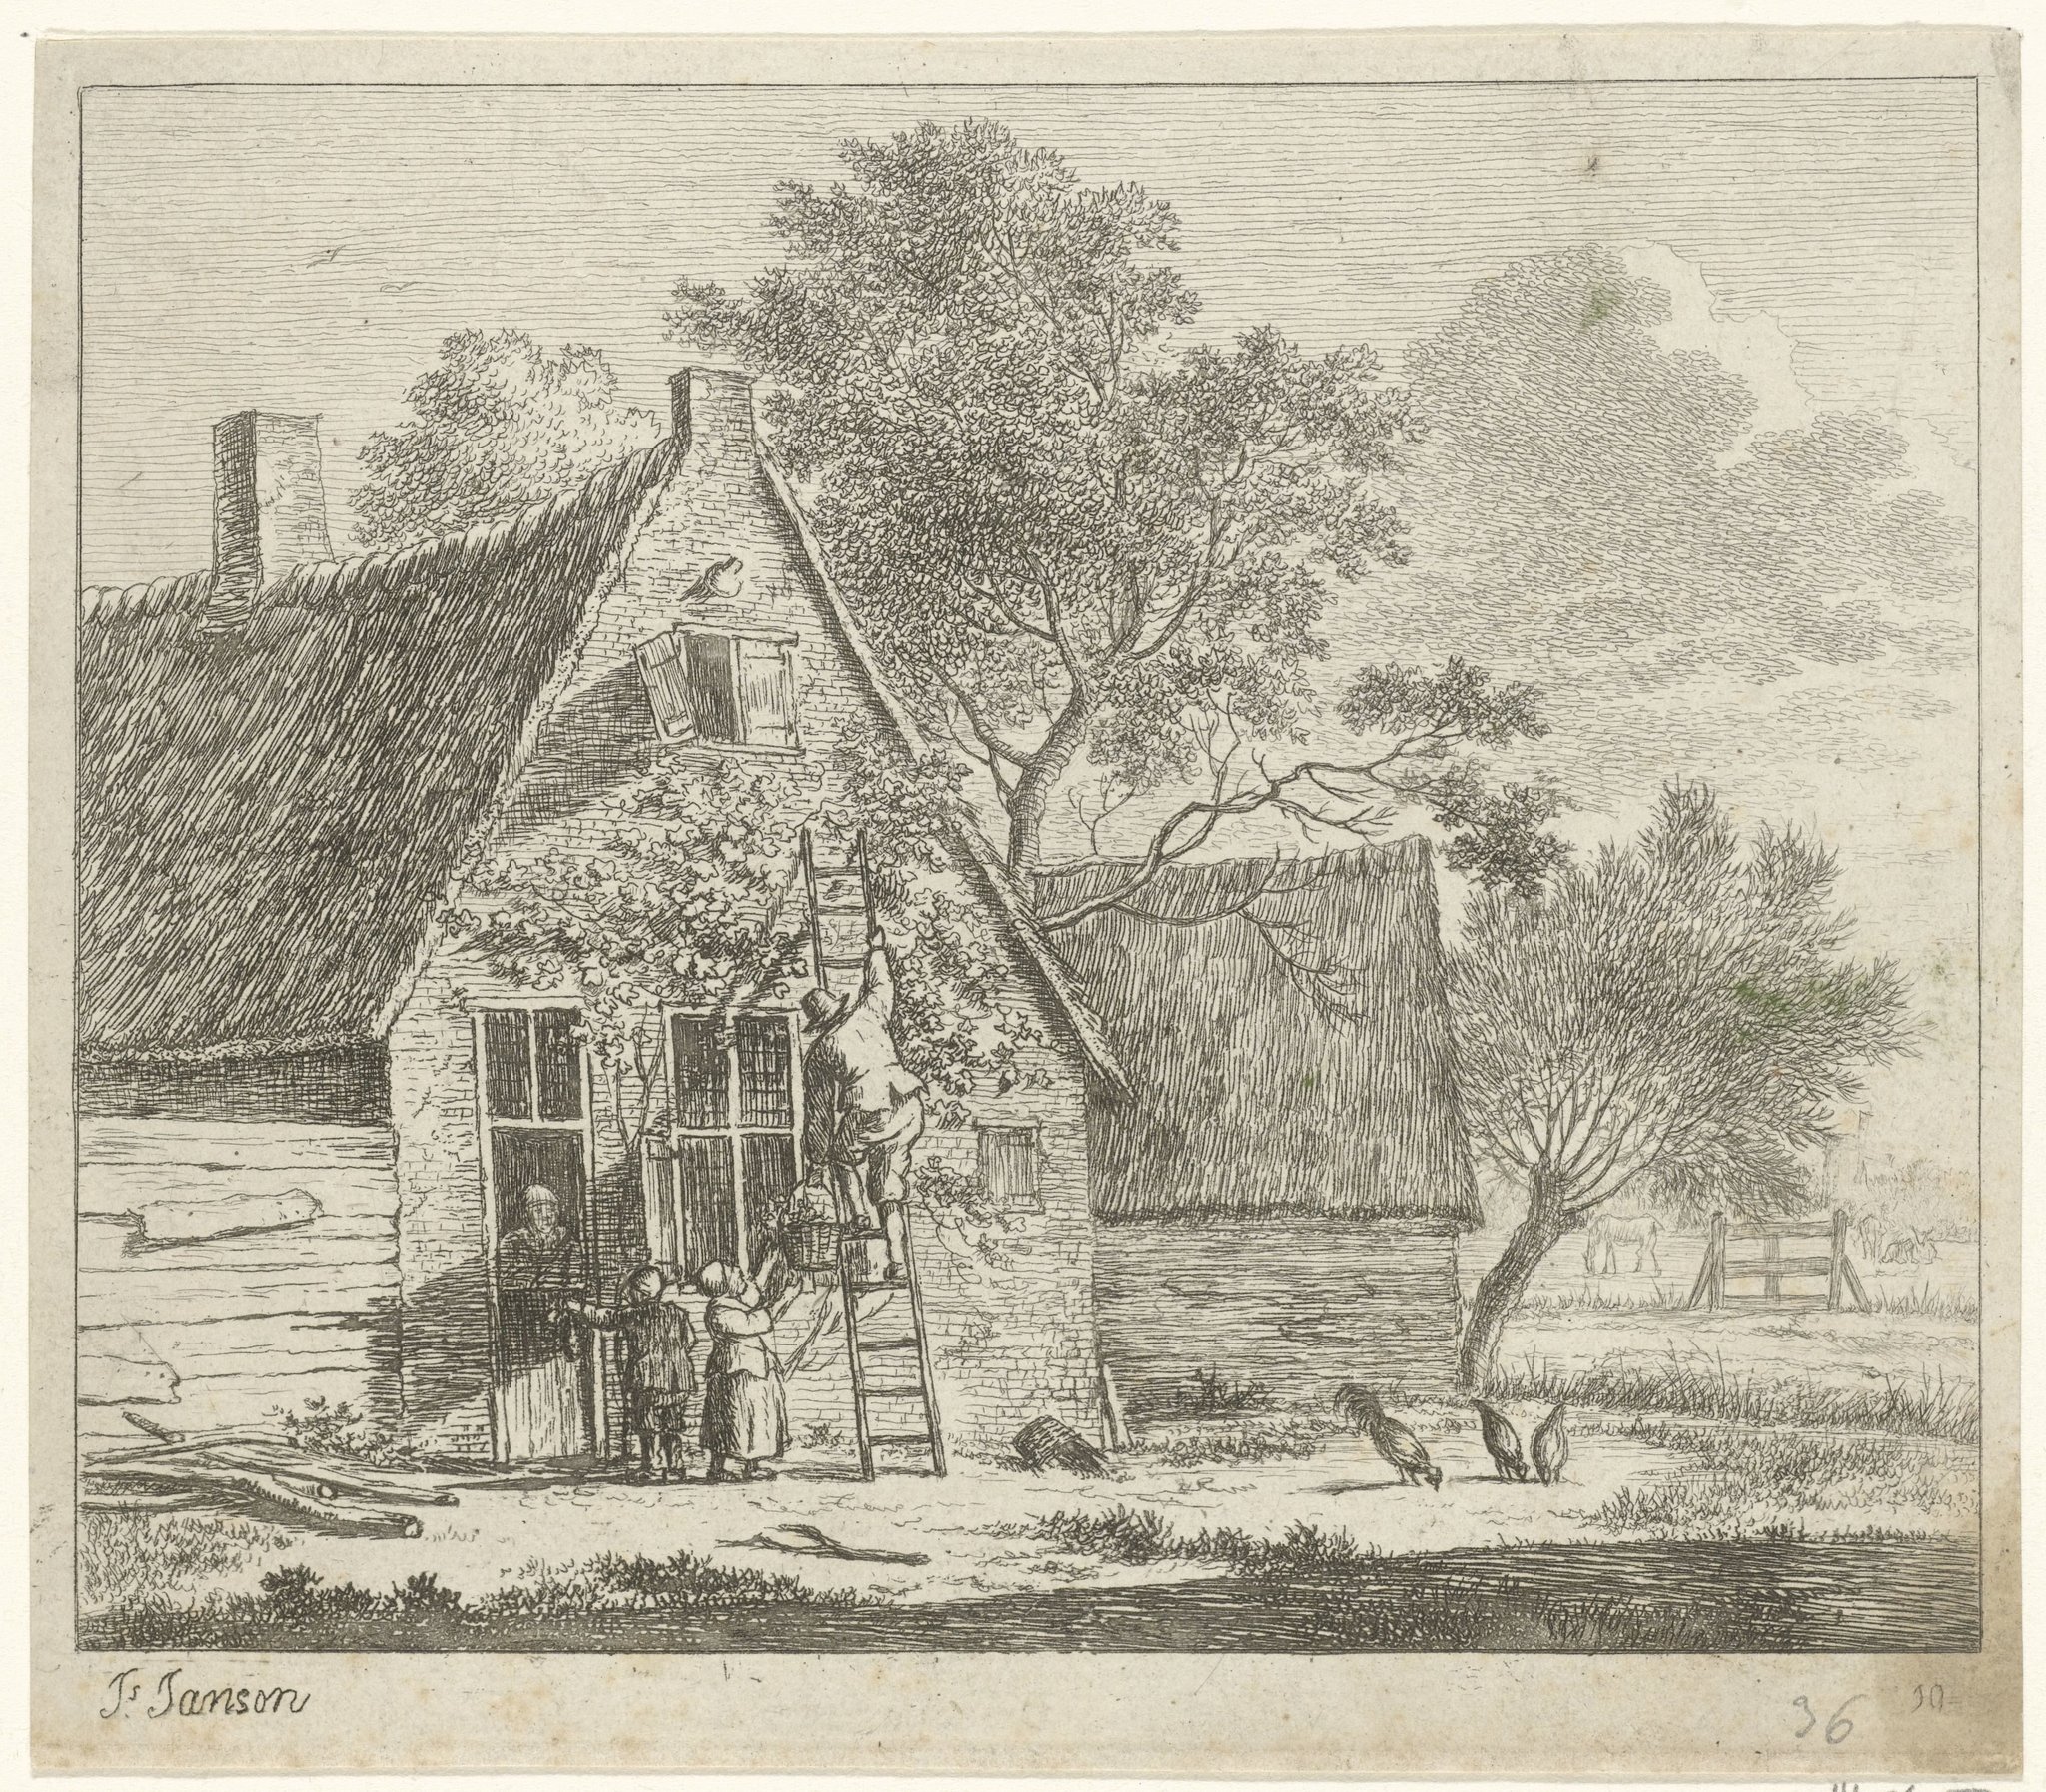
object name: print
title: Boerderij met erf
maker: johannes janson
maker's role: draughtsman, painter, print maker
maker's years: 1729-1784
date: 1783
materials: paper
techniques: etching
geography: leiden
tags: landscape symbolizing october, vintage, grape harvest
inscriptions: collector's mark: Lugt 2228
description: Boerenerf met boerderij en vier figuren. Een ladder staat tegen de gevel van de boerderij, waarop een man die druiven plukt. Een vrouw pakt de mand aan. Rechts drie kippen op het erf. Rechtsonder: 10. Elfde prent uit een serie van dertien met maanden.